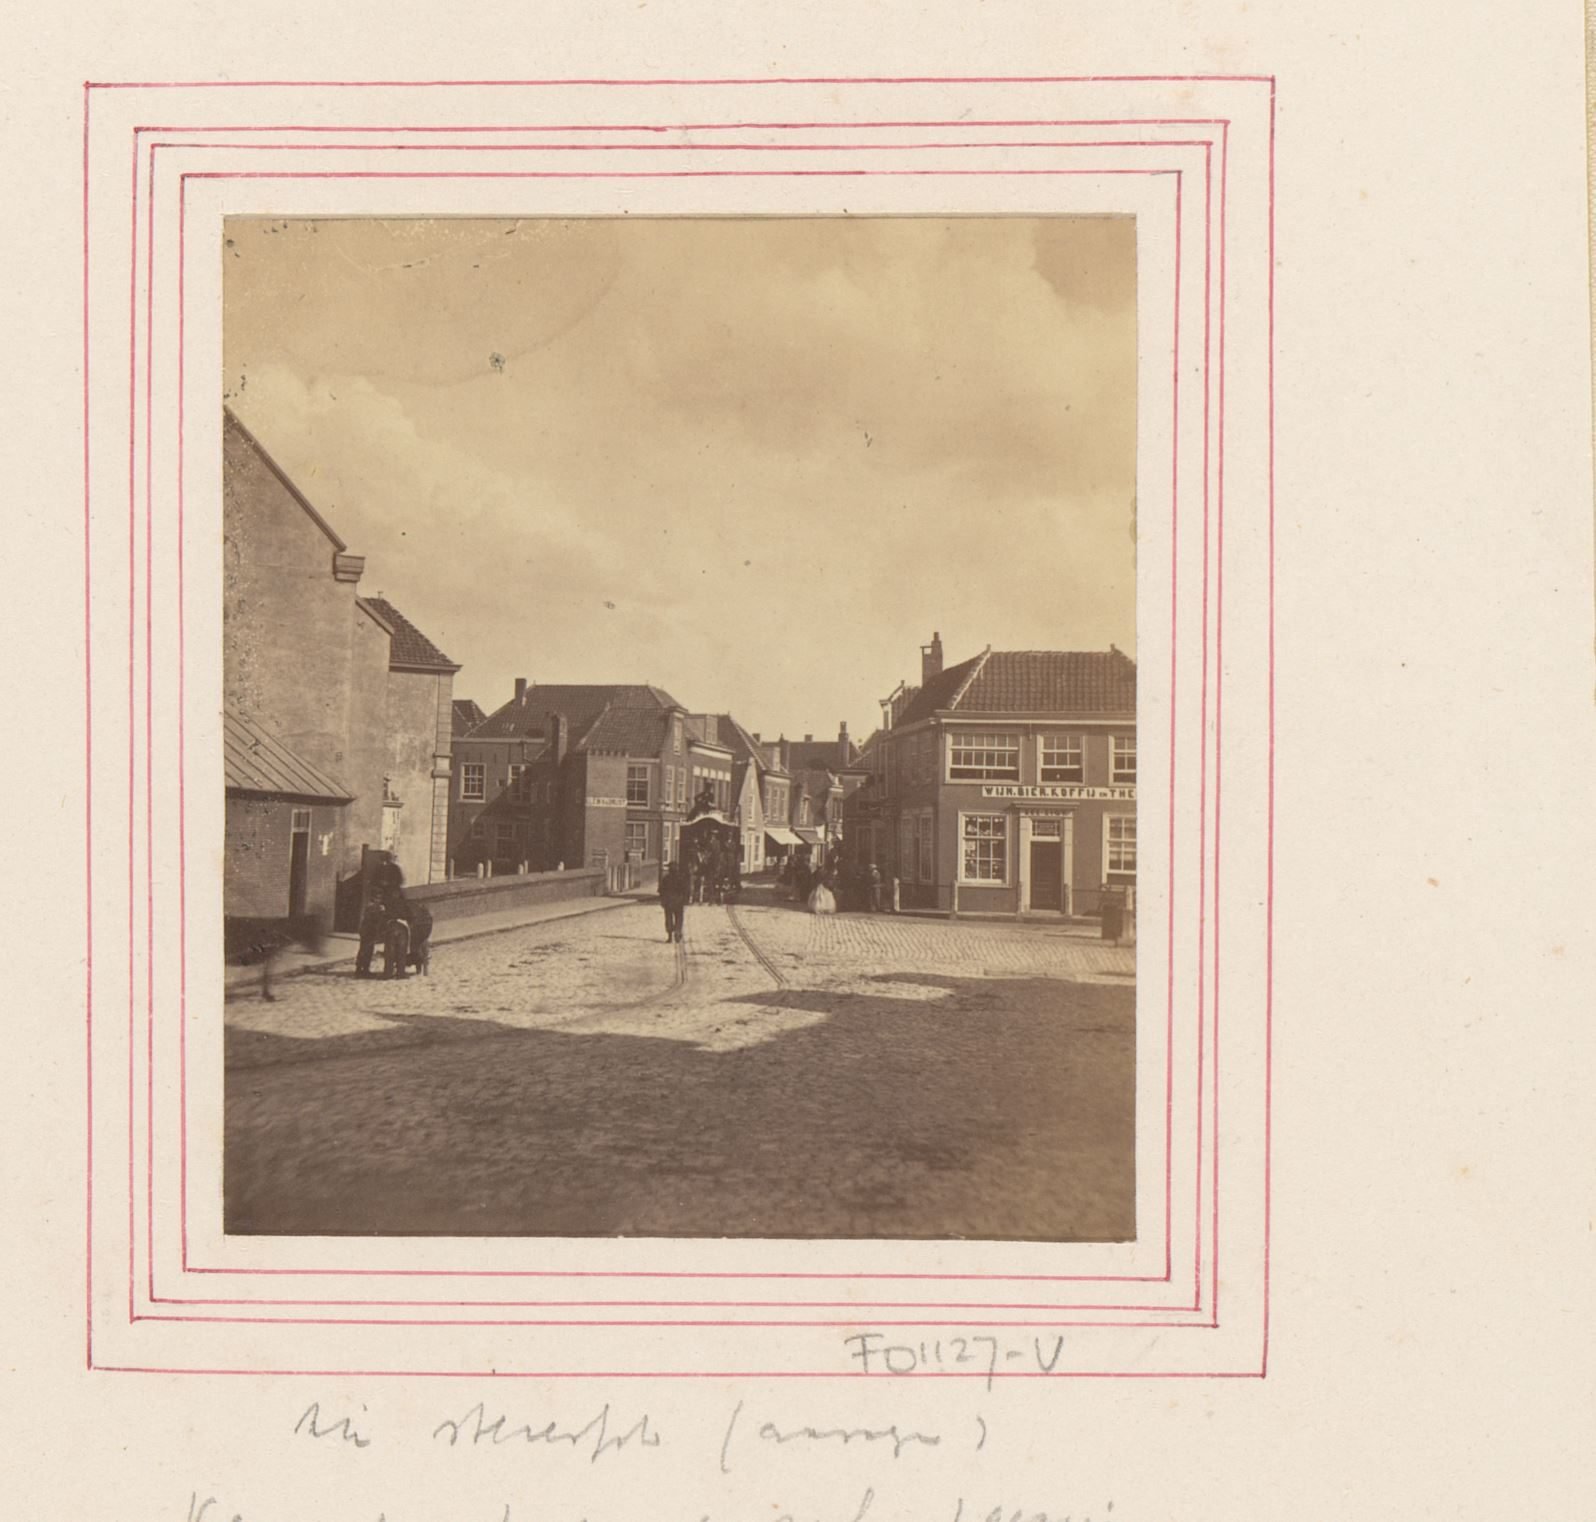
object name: photograph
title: Keizerstraat in Scheveningen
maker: Anonymous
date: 1870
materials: photographic support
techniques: albumen print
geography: scheveningen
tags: street (+ city(-scape) with figures, staffage)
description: Onderdeel van Album met foto's en litho's van bezienswaardigheden in Noord- en Zuid-Hollandse steden, schilderijen en klederdrachten.